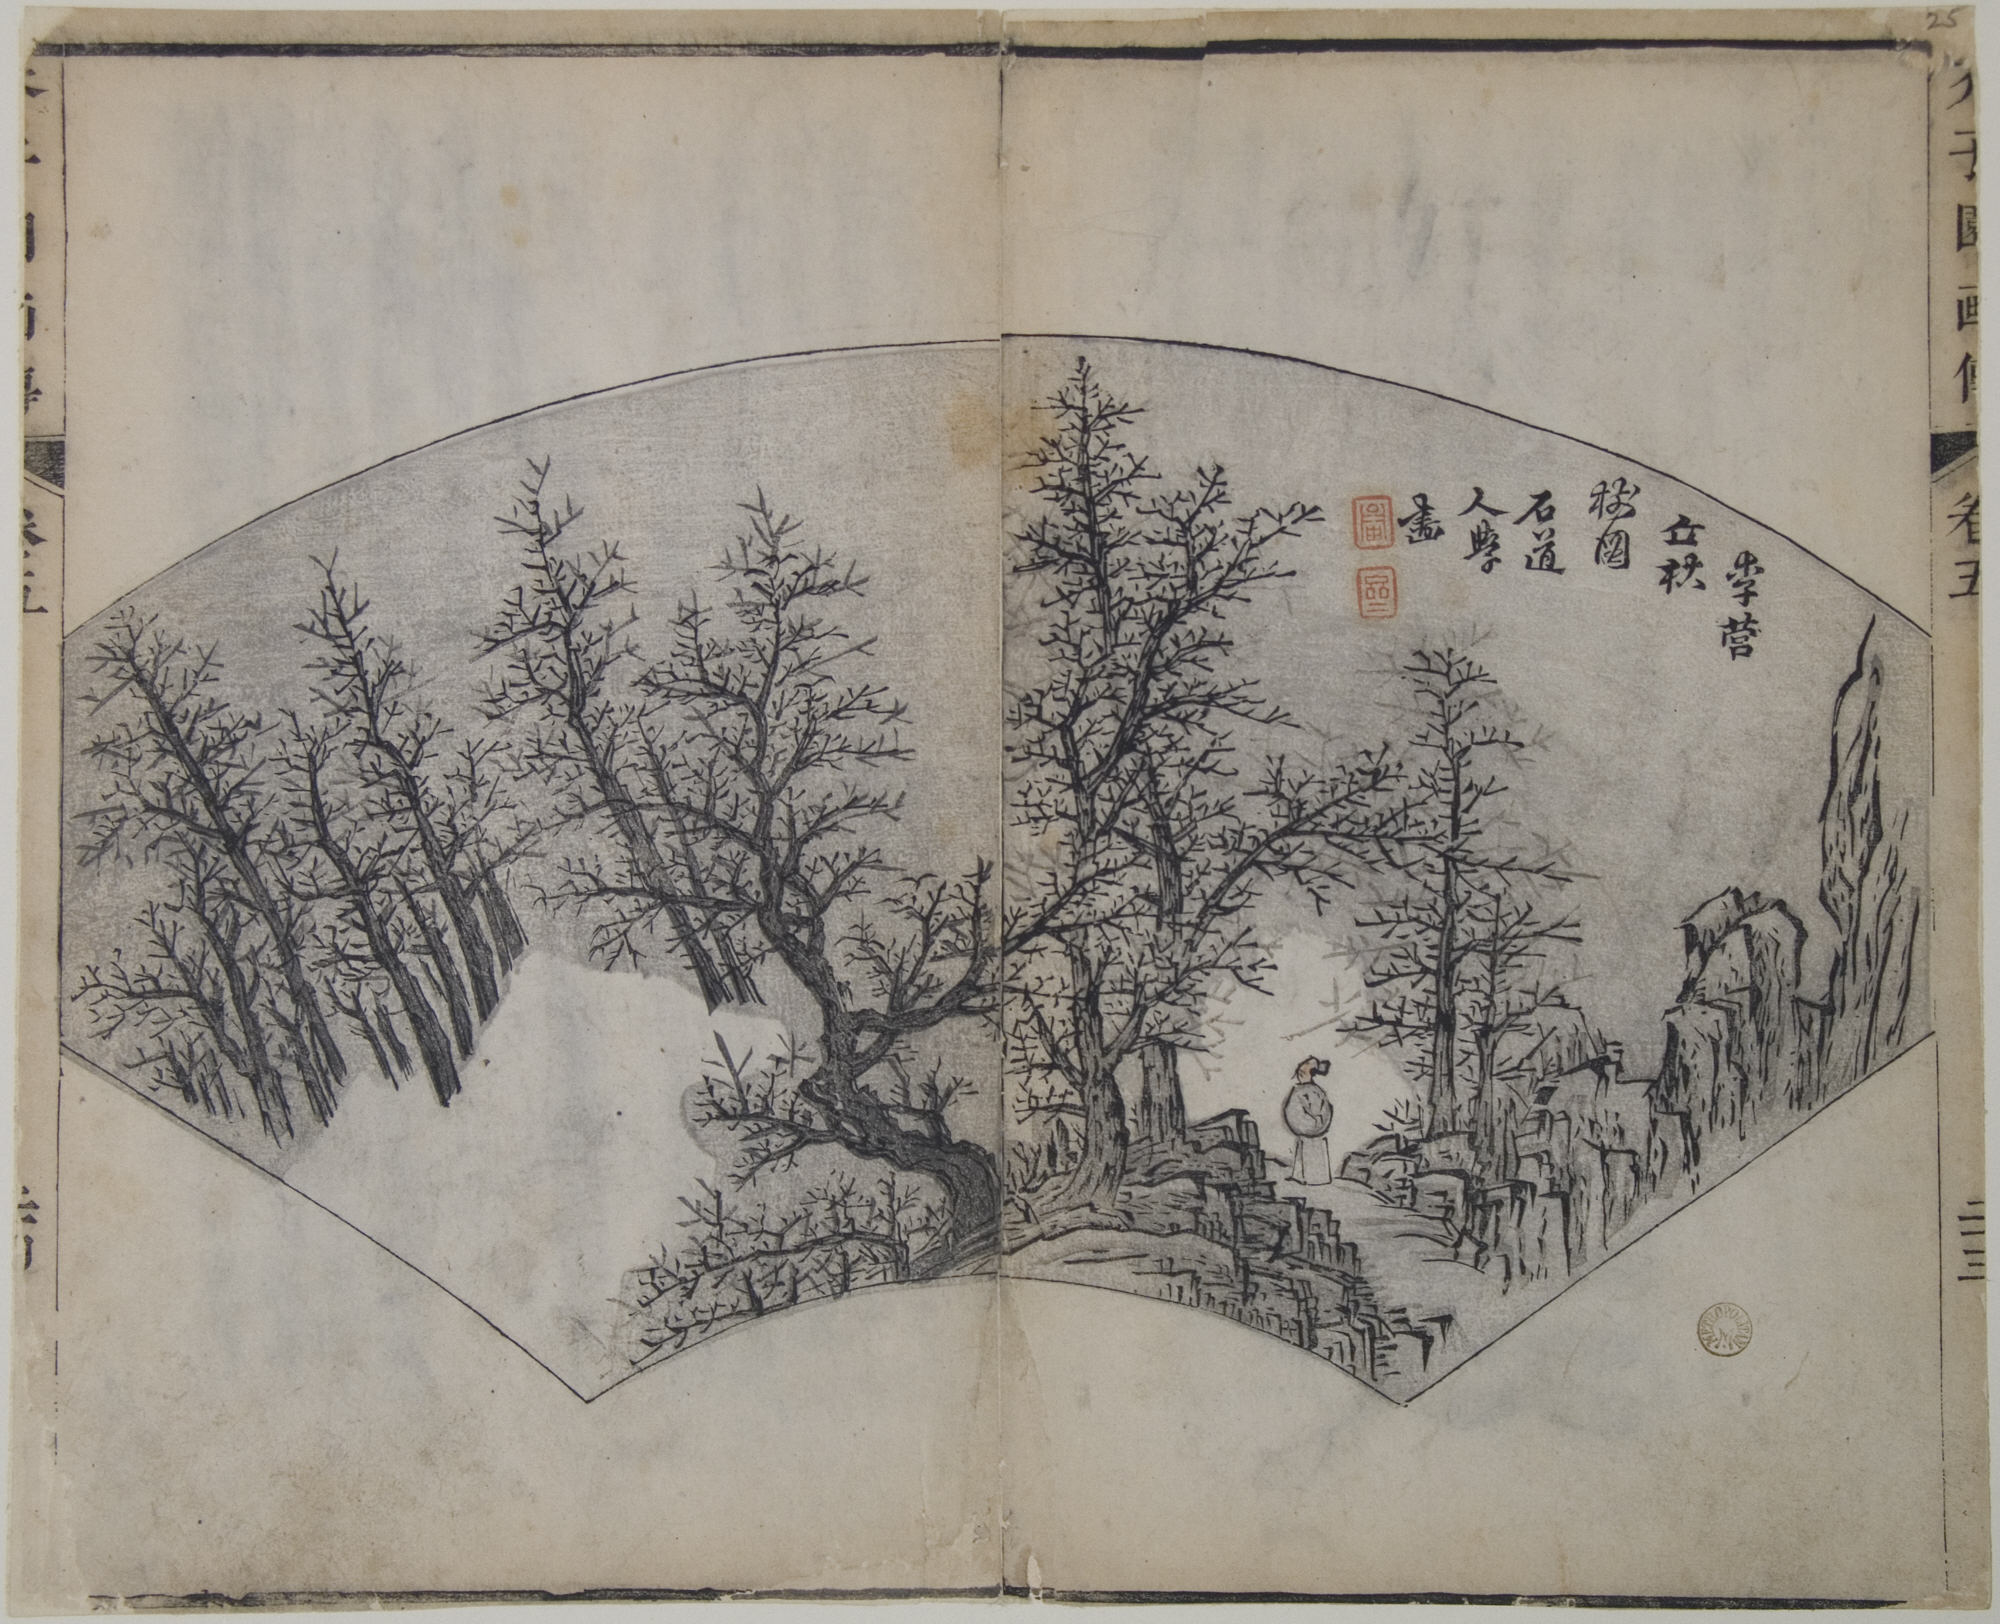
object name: print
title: Page from the Mustard Seed Garden Manual of Painting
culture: chinese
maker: wang gai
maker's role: artist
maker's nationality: chinese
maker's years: 1645-1710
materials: ink, paper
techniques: woodblock print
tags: trees